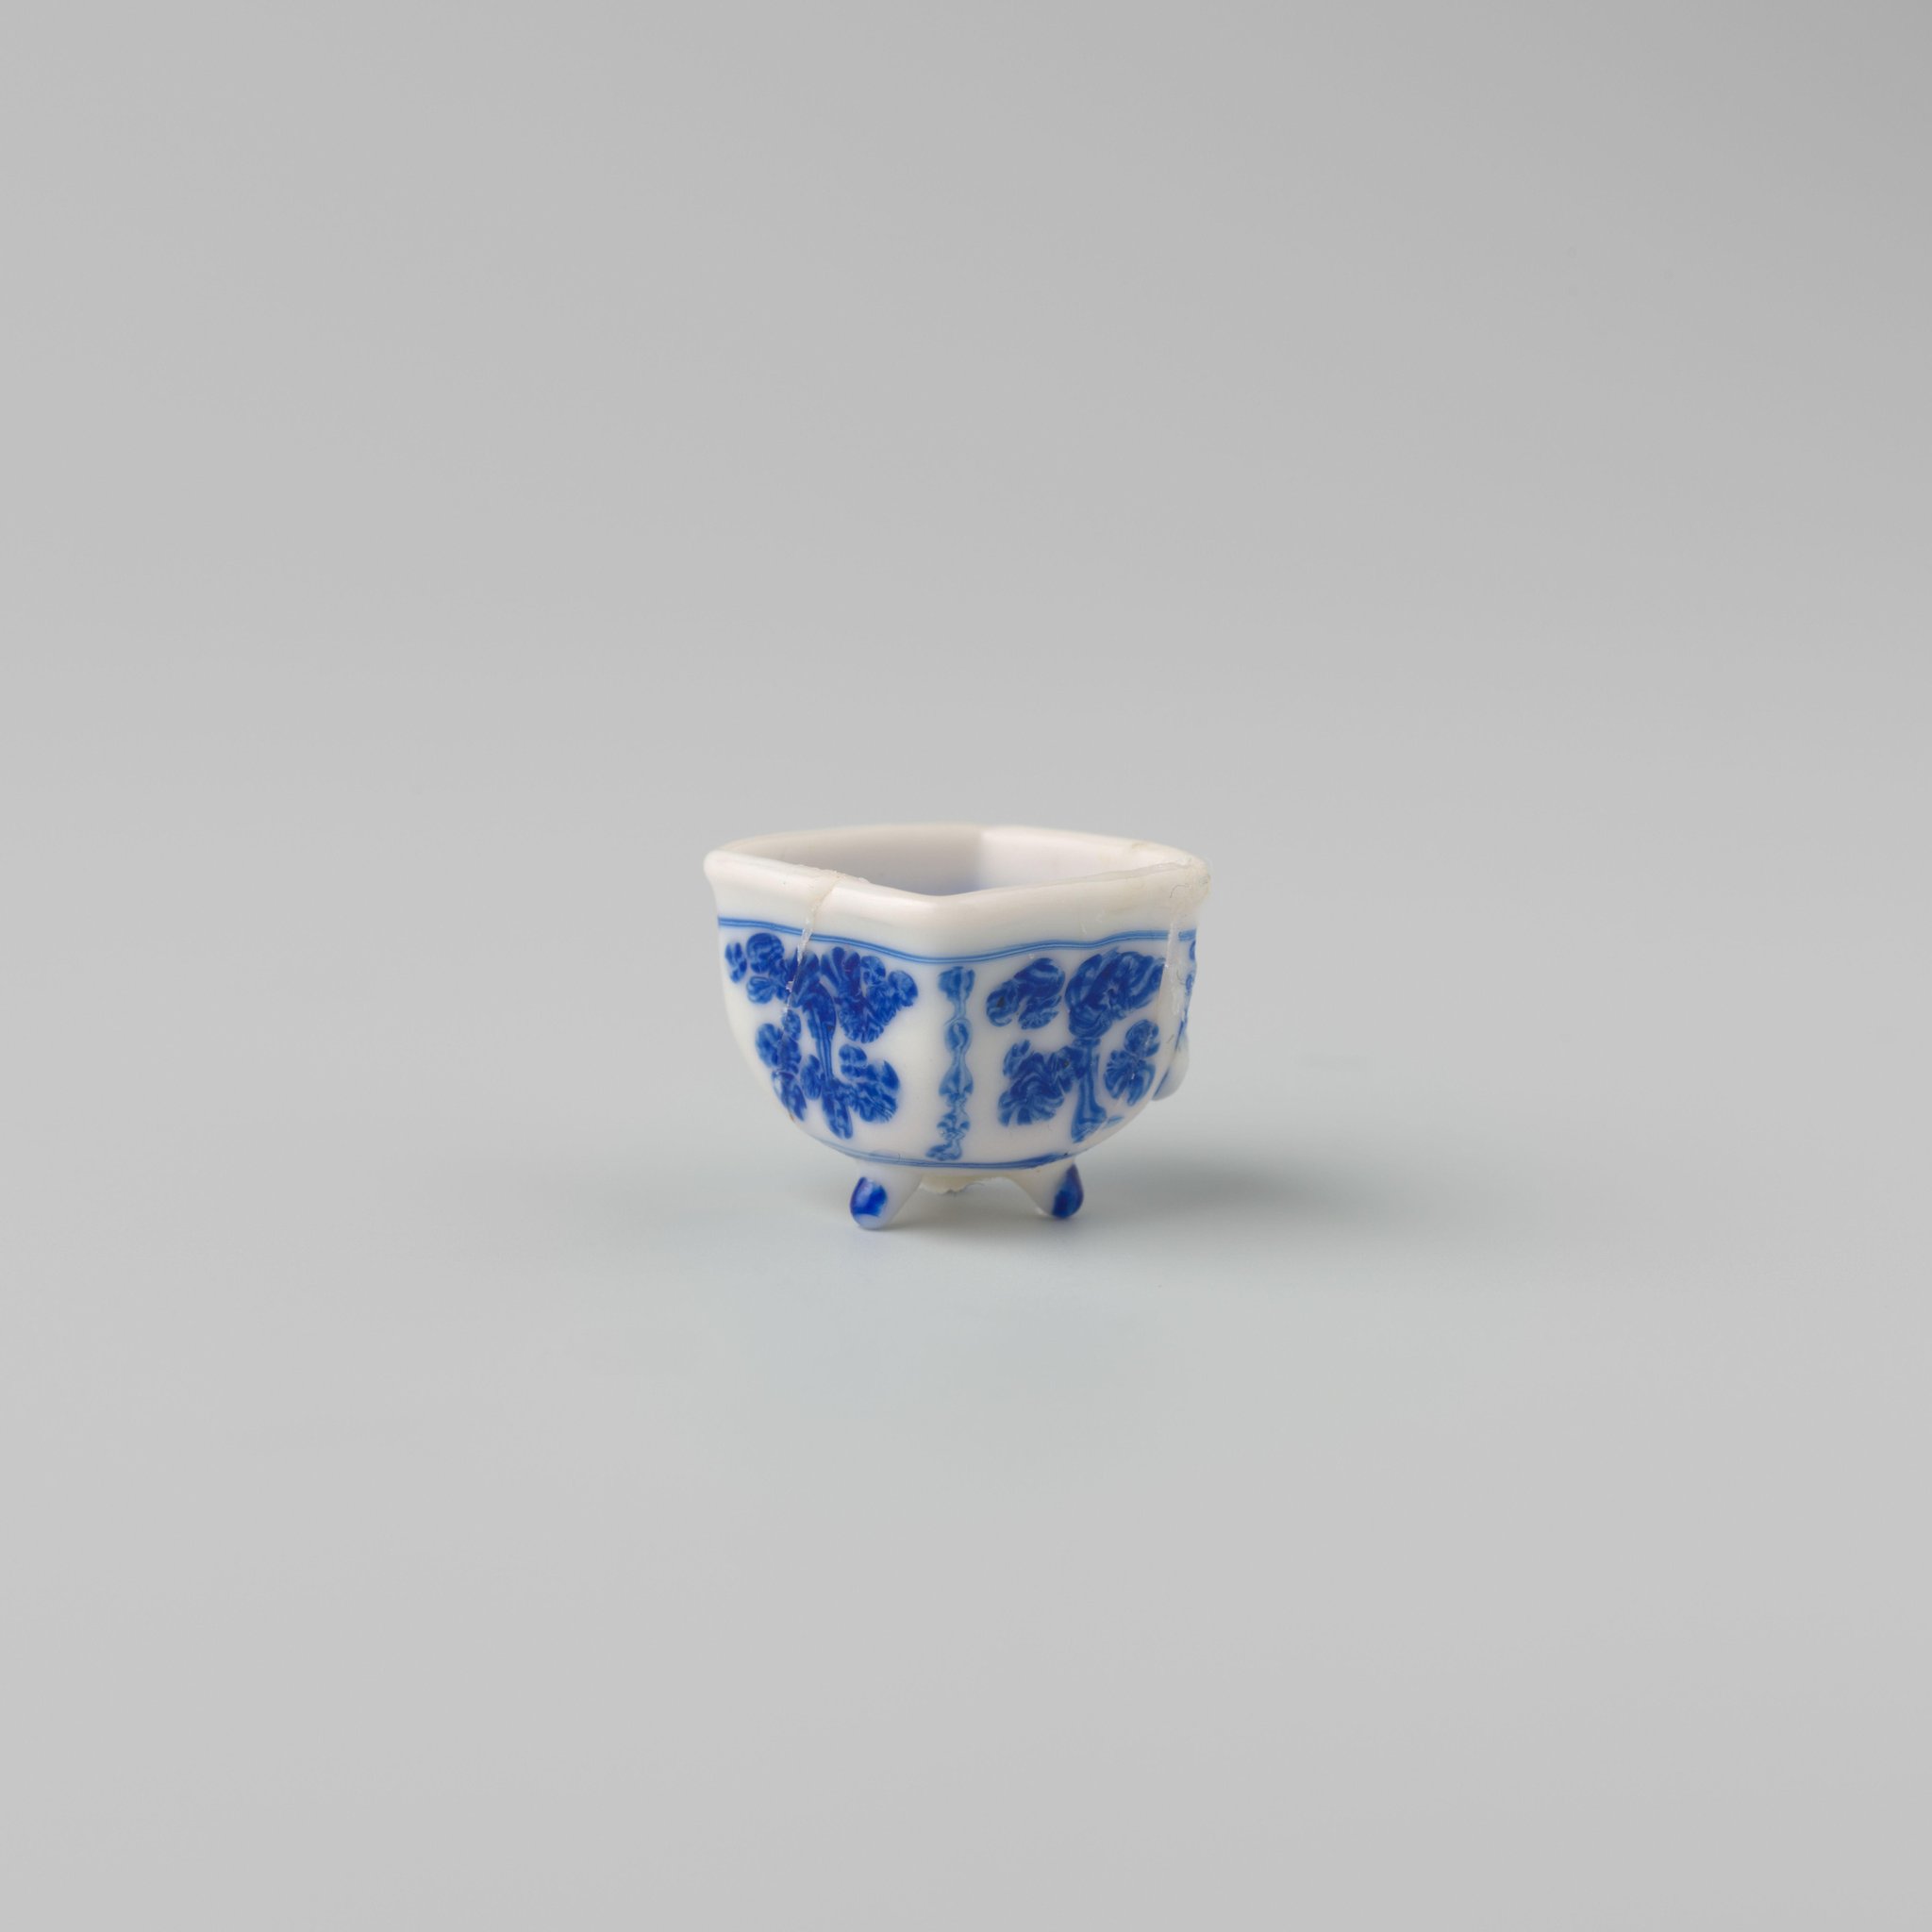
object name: vuurtest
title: Vuurtest van melkglas met blauwe emailverf beschildering, imitatie Chinees porselein; vierkant bakje op drie pootjes met oor; decoratie van bloemmotieven in vier vakken.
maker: Anonymous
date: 1675-1710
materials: glass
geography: amsterdam